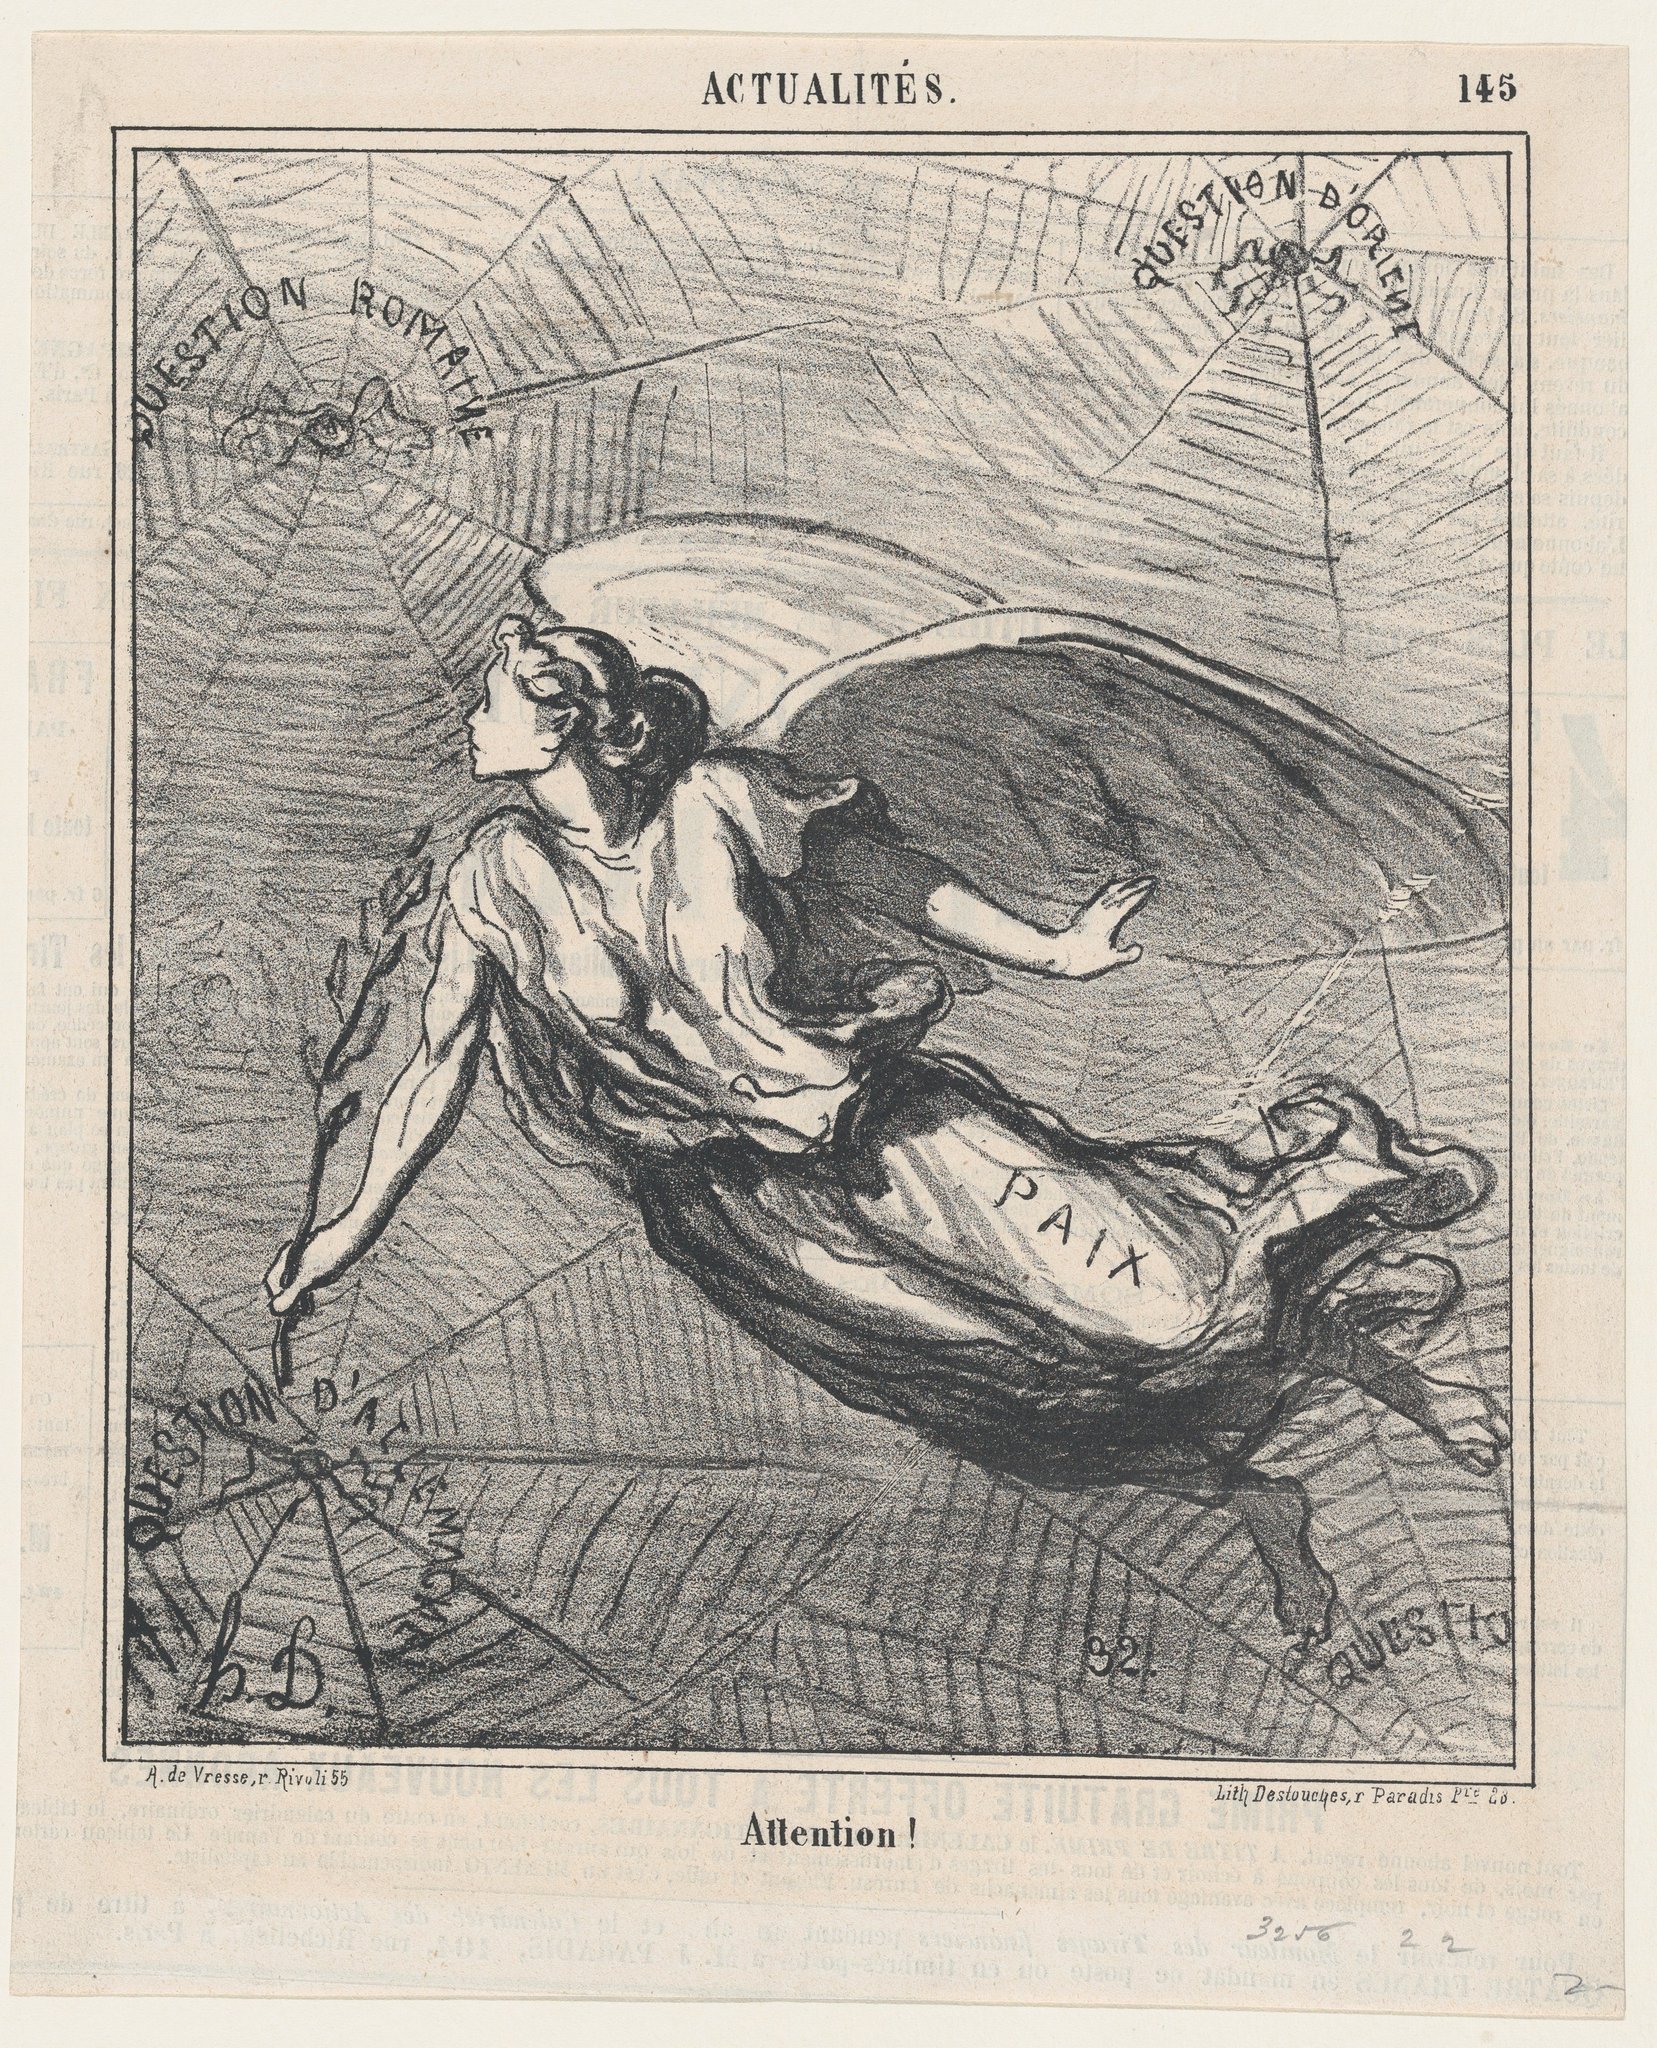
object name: print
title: Look out!, from 'News of the day,' published in "Le Charivari"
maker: honoré daumier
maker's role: artist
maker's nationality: french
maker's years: 1808-1879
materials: paper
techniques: lithograph